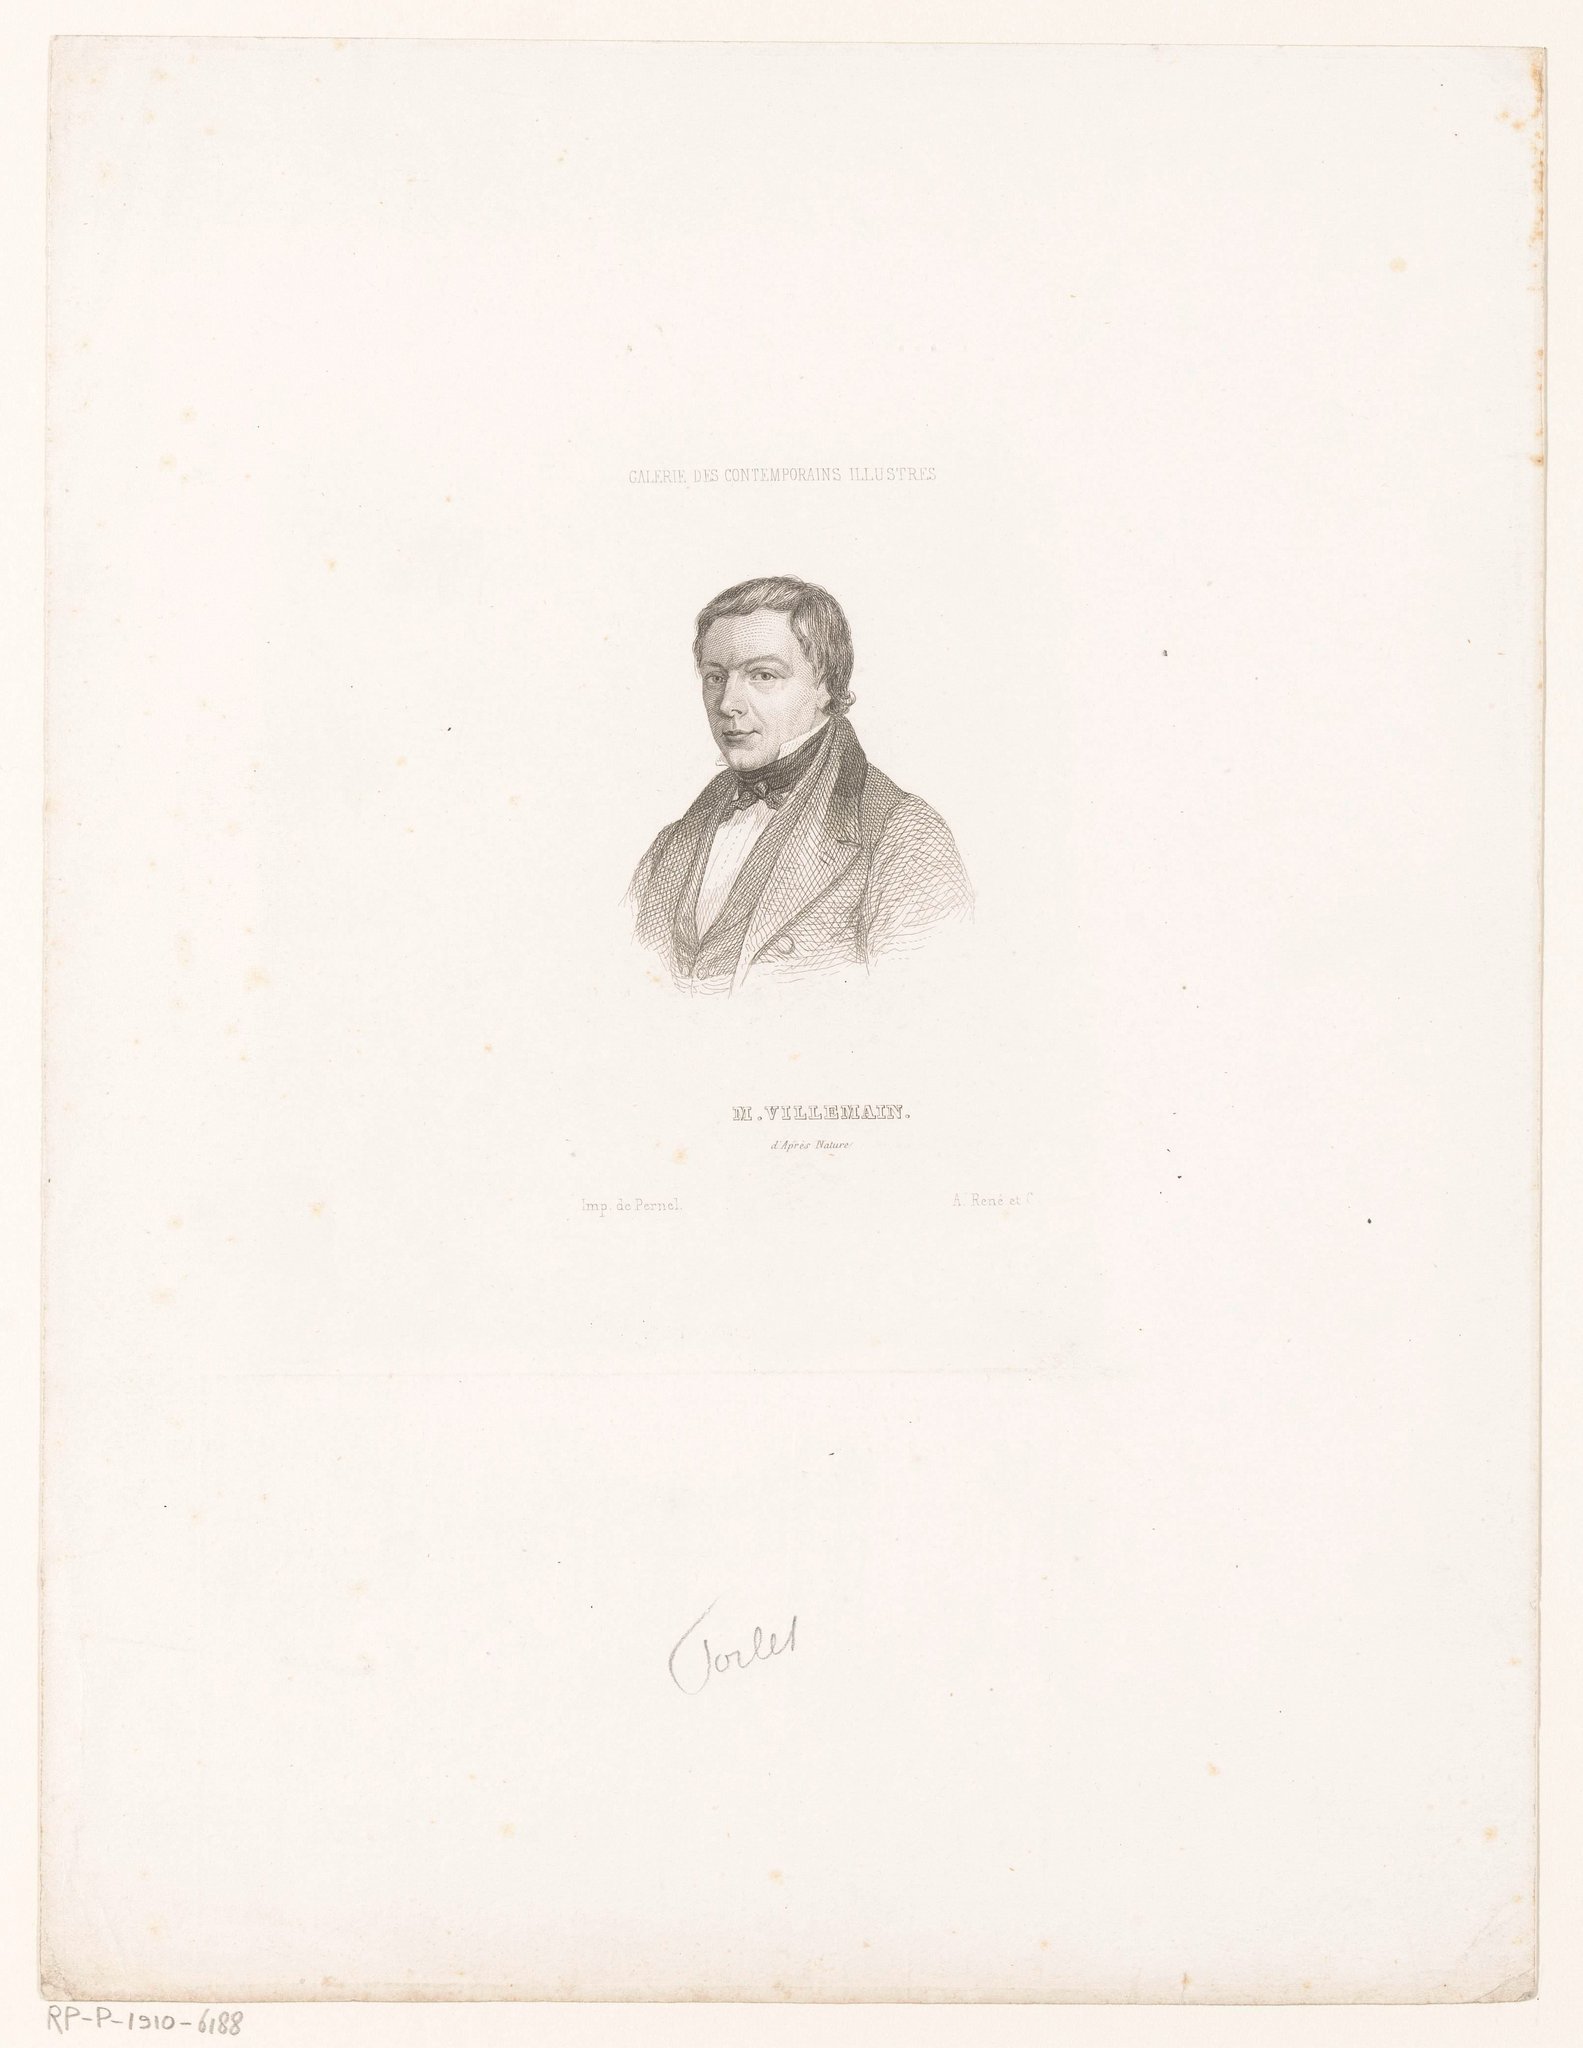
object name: print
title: Galerie des contemporains illustres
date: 1845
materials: paper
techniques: etching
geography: paris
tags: paris, politician, historical persons, portrait of a writer, politician, e.g. party leader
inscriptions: collector's mark: Lugt 2228